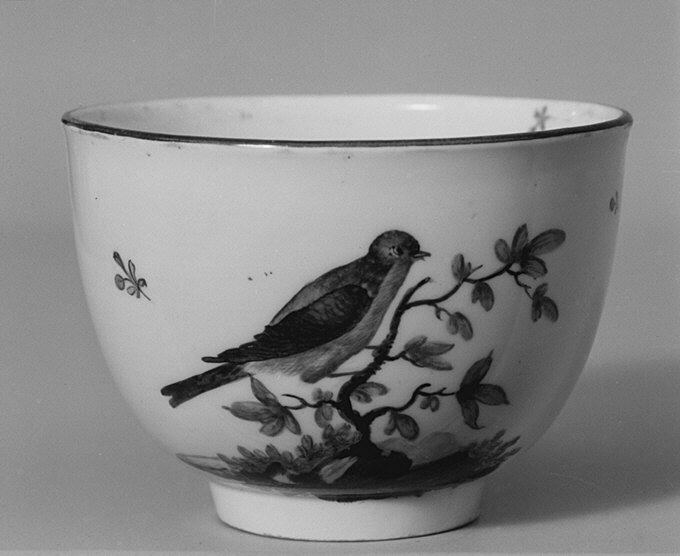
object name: cup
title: Cup (part of a service)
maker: frankenthal porcelain manufactory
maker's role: manufactory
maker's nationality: german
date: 1770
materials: hard paste porcelain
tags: birds,plants